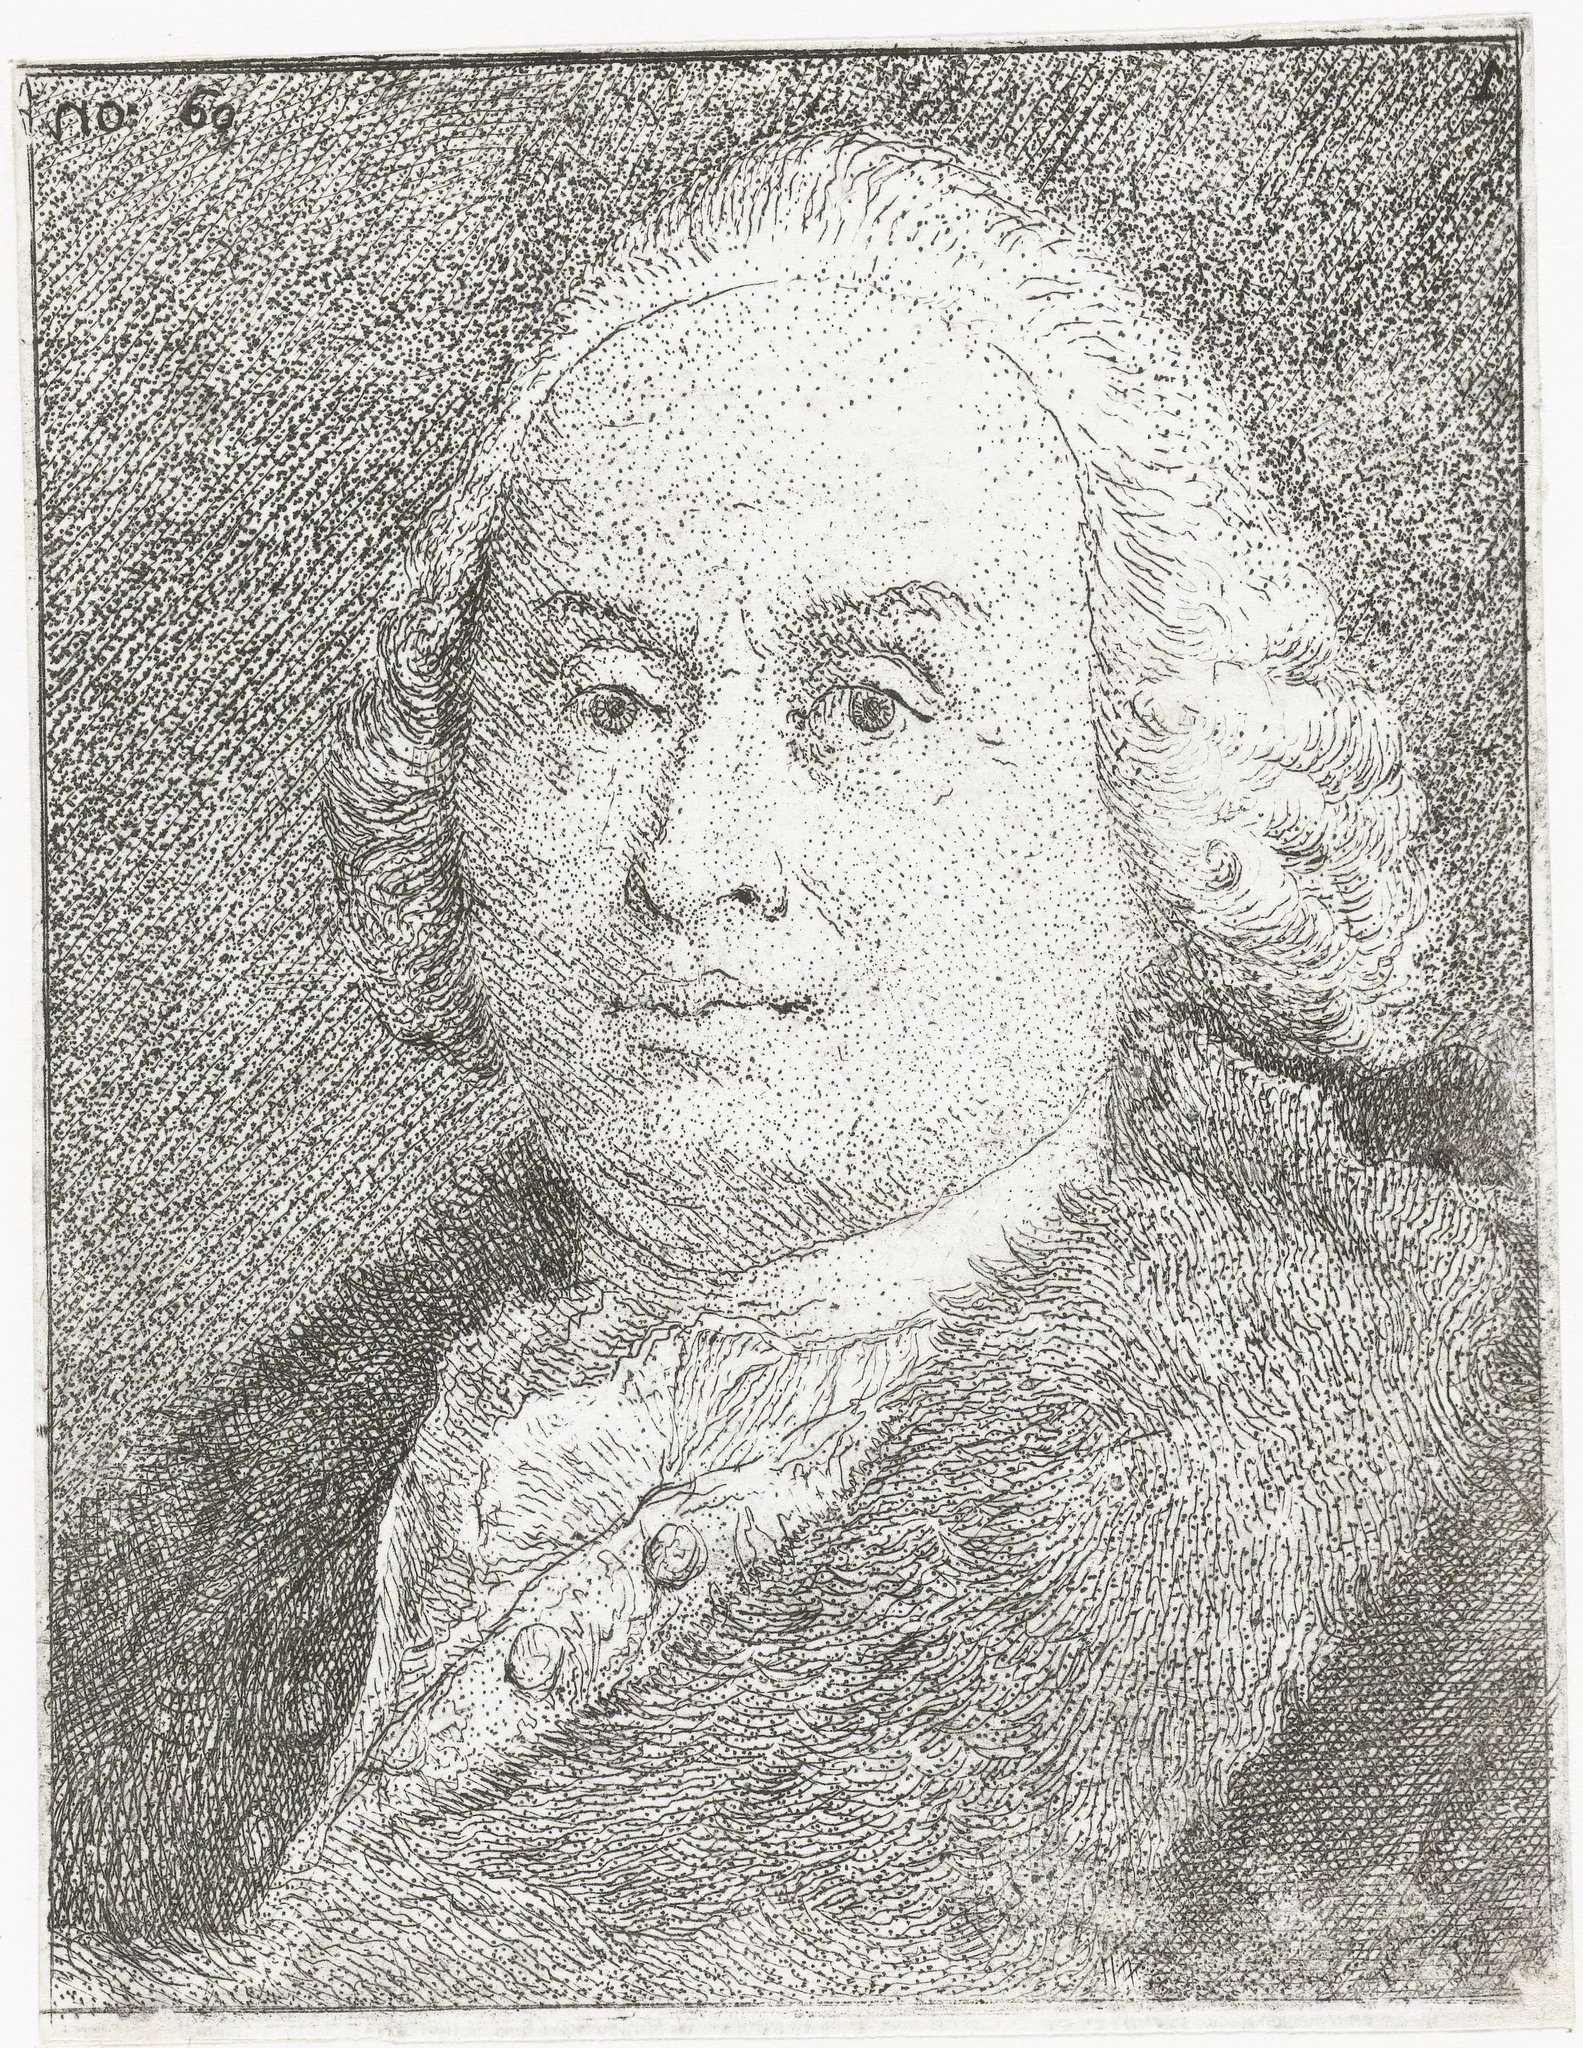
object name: print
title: Portret van Giovanni Battista Tiepolo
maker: giovanni domenico tiepolo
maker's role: draughtsman, print maker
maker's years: 1727-1804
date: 1771-1774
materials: paper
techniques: etching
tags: painter, giovanni battista tiepolo, portrait, self-portrait of painter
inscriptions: collector's mark: Lugt 2228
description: Prent uit serie Verzameling hoofden (Raccolta di teste). Giovanni Domenico Tiepolo vervaardigde in de winter van 1757-1758 en in de periode van 1771-1774 deze hoofden naar schilderijen en tekeningen van Giovanni Battista Tiepolo. De eerste uitgave verscheen in 1774 in twee delen met elk dertig prenten. Dit portret naar een tekening van Lorenzo Baldissera Tiepolo werd als eerste prent opgenomen in deel 1.